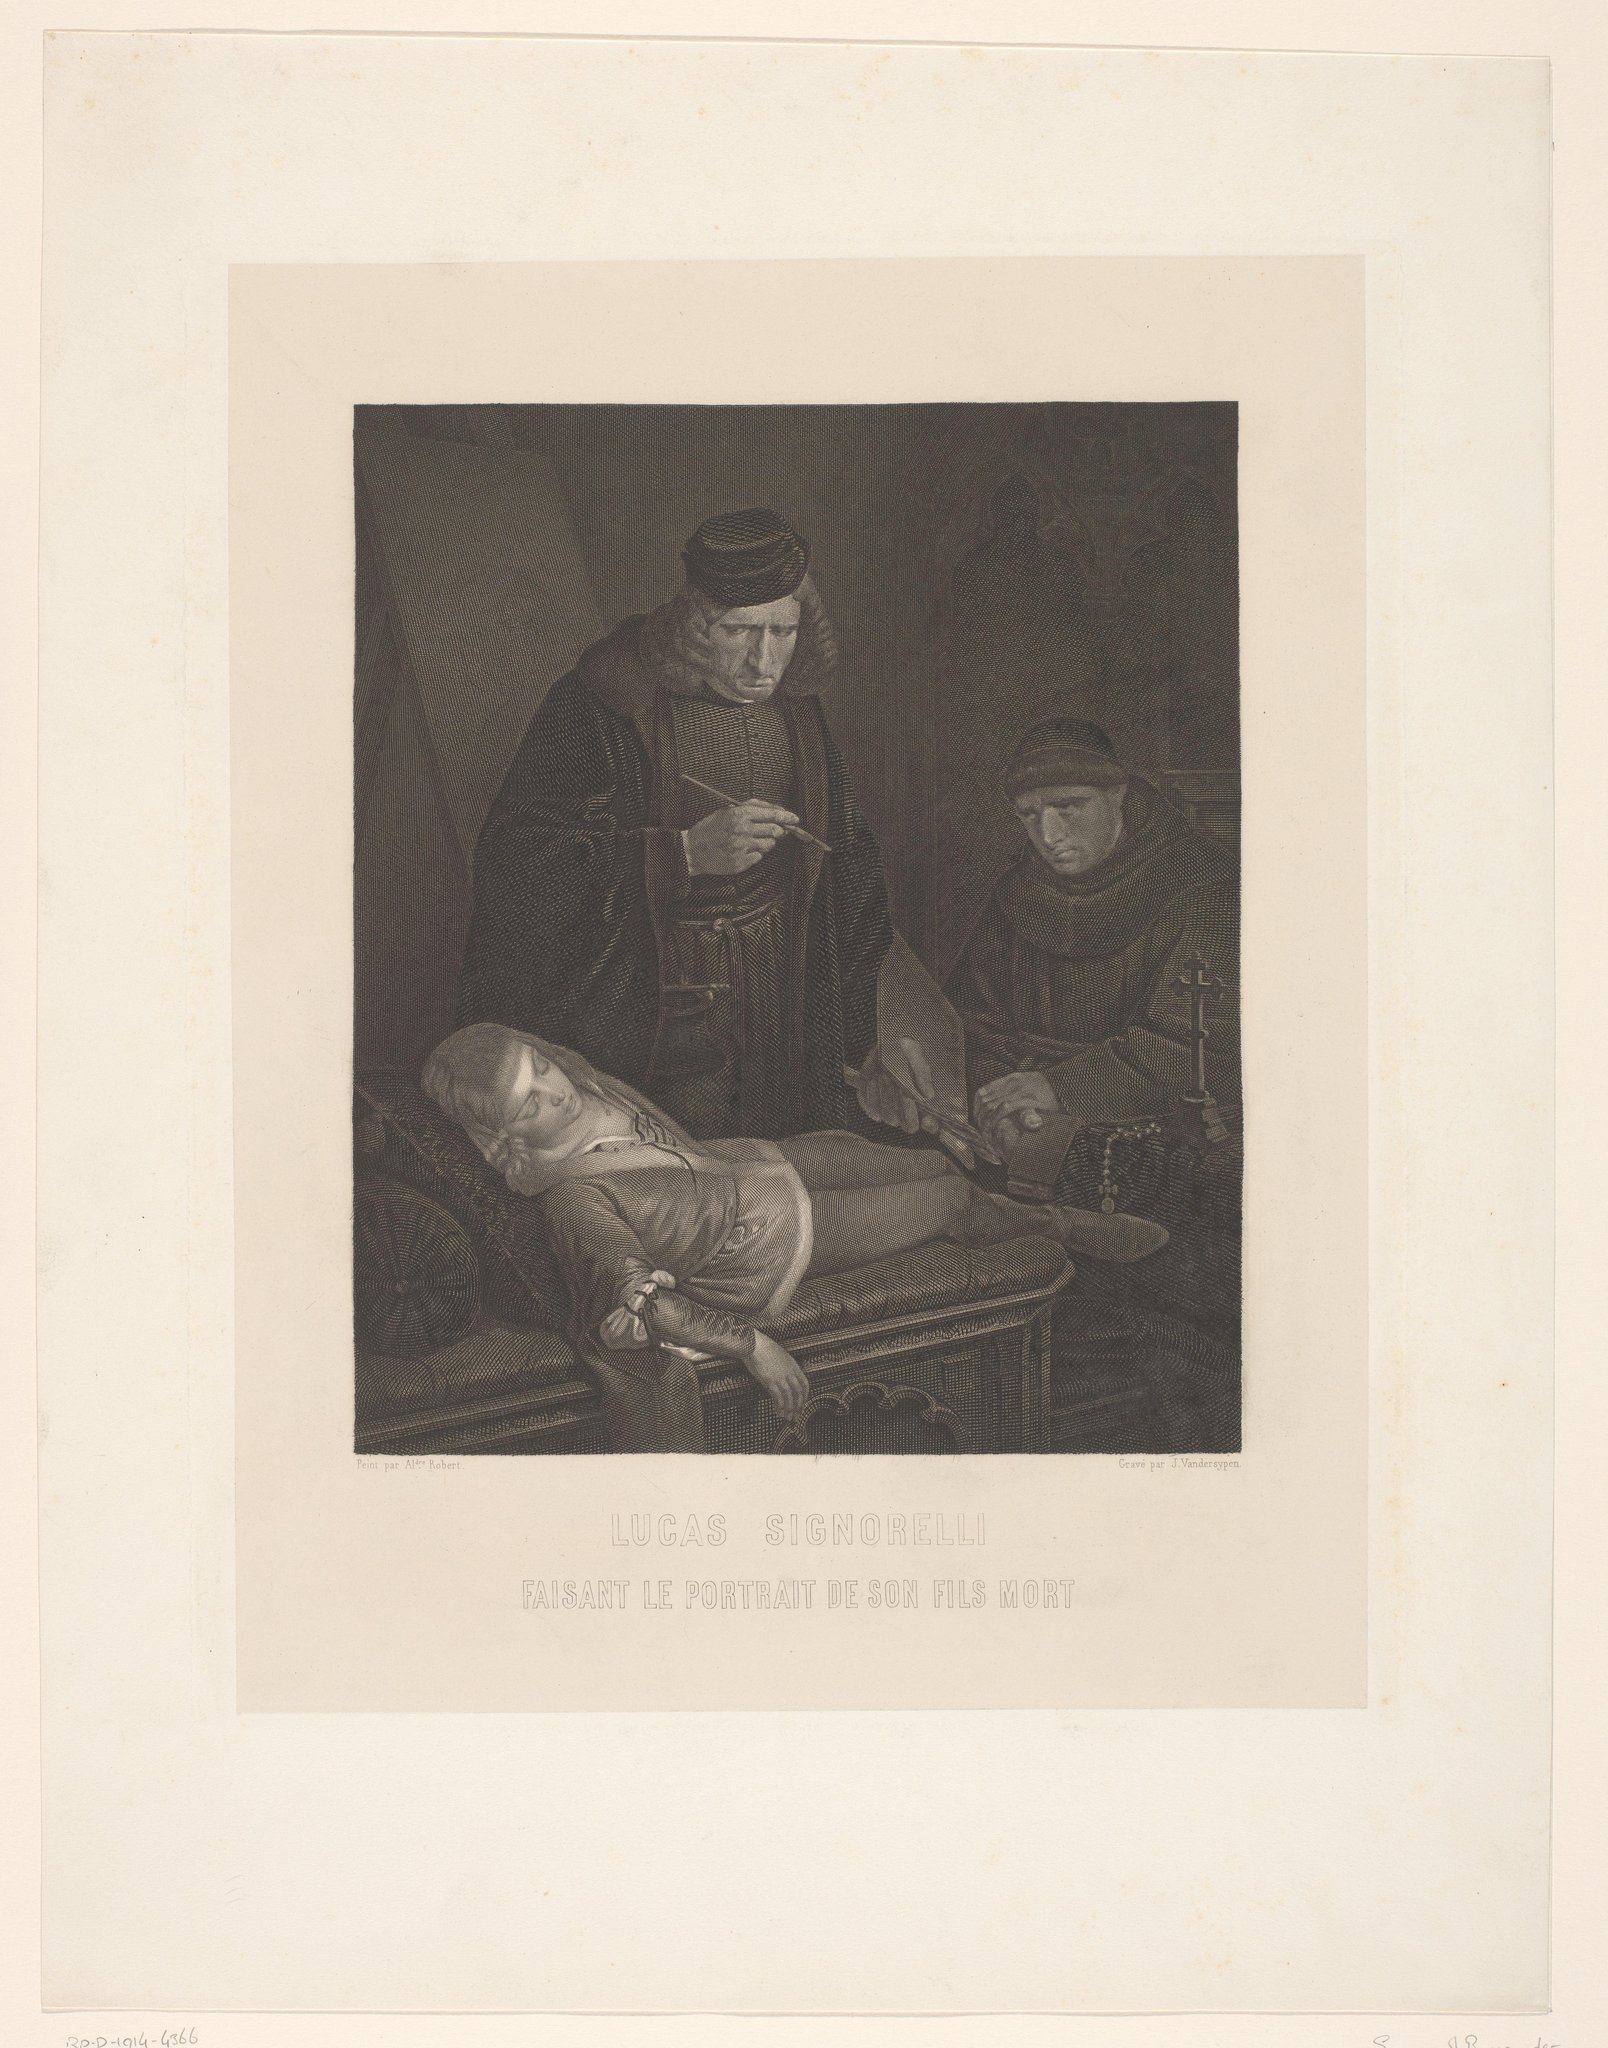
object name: print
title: Luca Signorelli portretteert zijn overleden zoon in het bijzijn van een monnik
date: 1850-1881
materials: paper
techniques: engraving, etching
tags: painter, luca signorelli, monk(s), friar(s), portrait, self-portrait of painter, painter at work, in his studio, lying in state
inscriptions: collector's mark: Lugt 2228